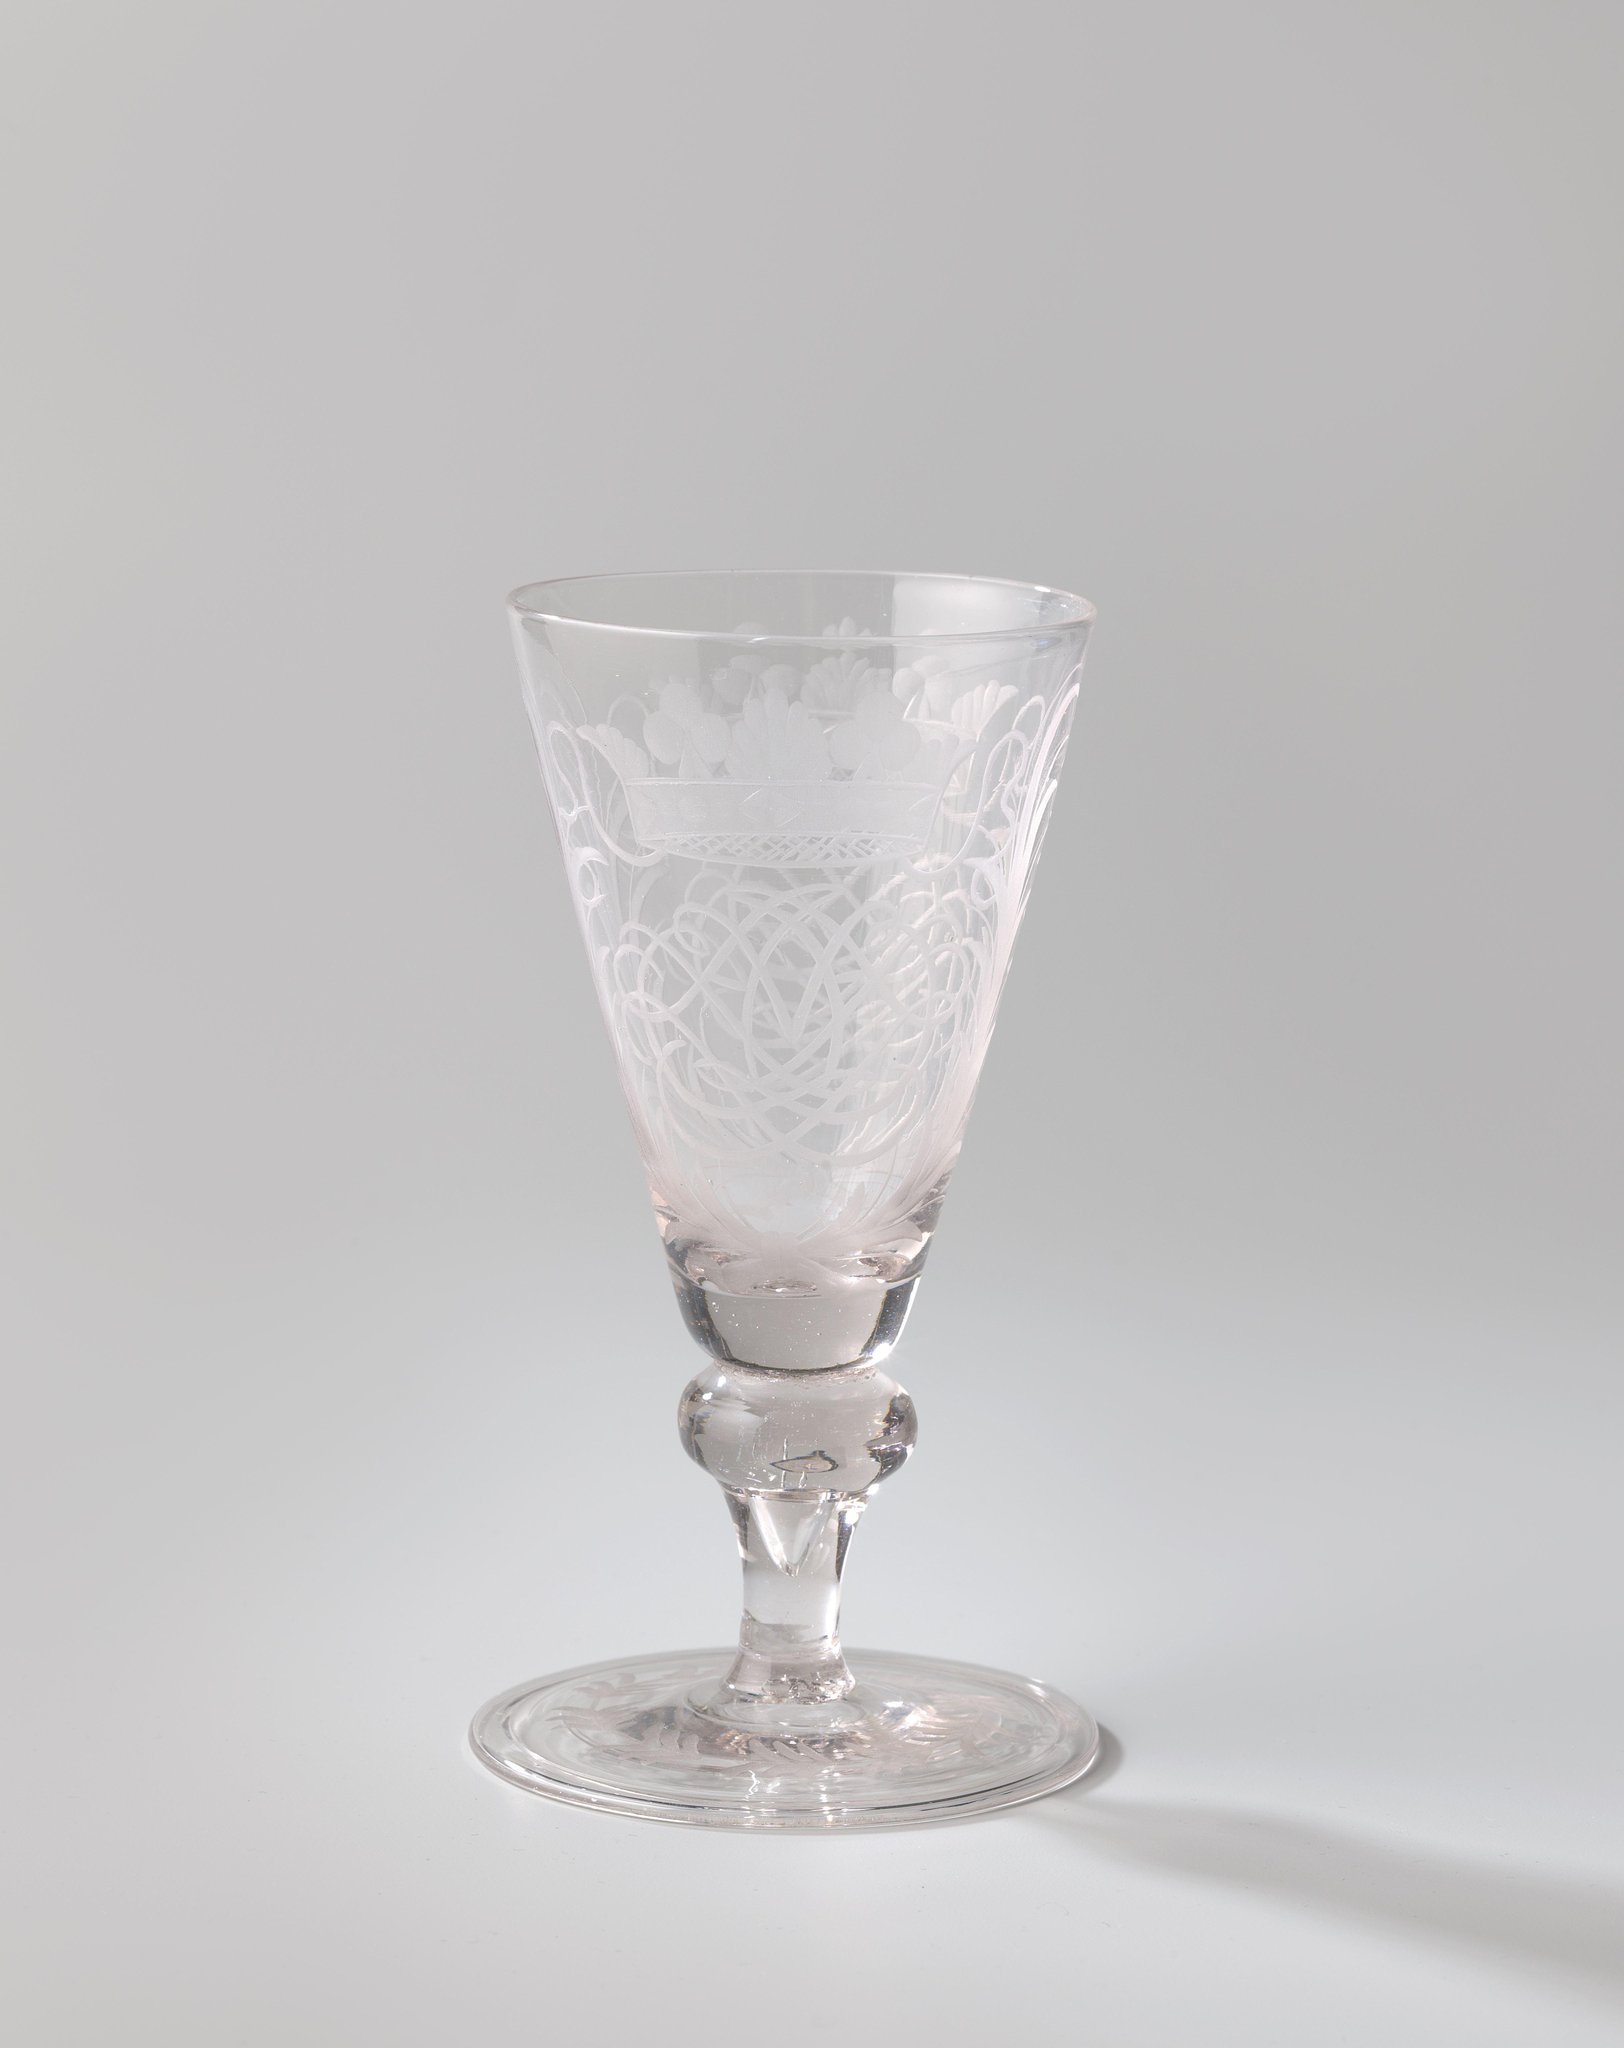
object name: goblet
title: Kelkglas met tweemaal het gekroonde monogram AVA tussen palmtakken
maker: Anonymous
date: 1700-1725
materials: glass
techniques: glassblowing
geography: northern netherlands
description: Kelkglas met hoge kelk en korte balusterstam. Op de kelk twee maal hetzelfde gekroonde monogram AVA tussen palmtakken. Op de voet een bladkrans.